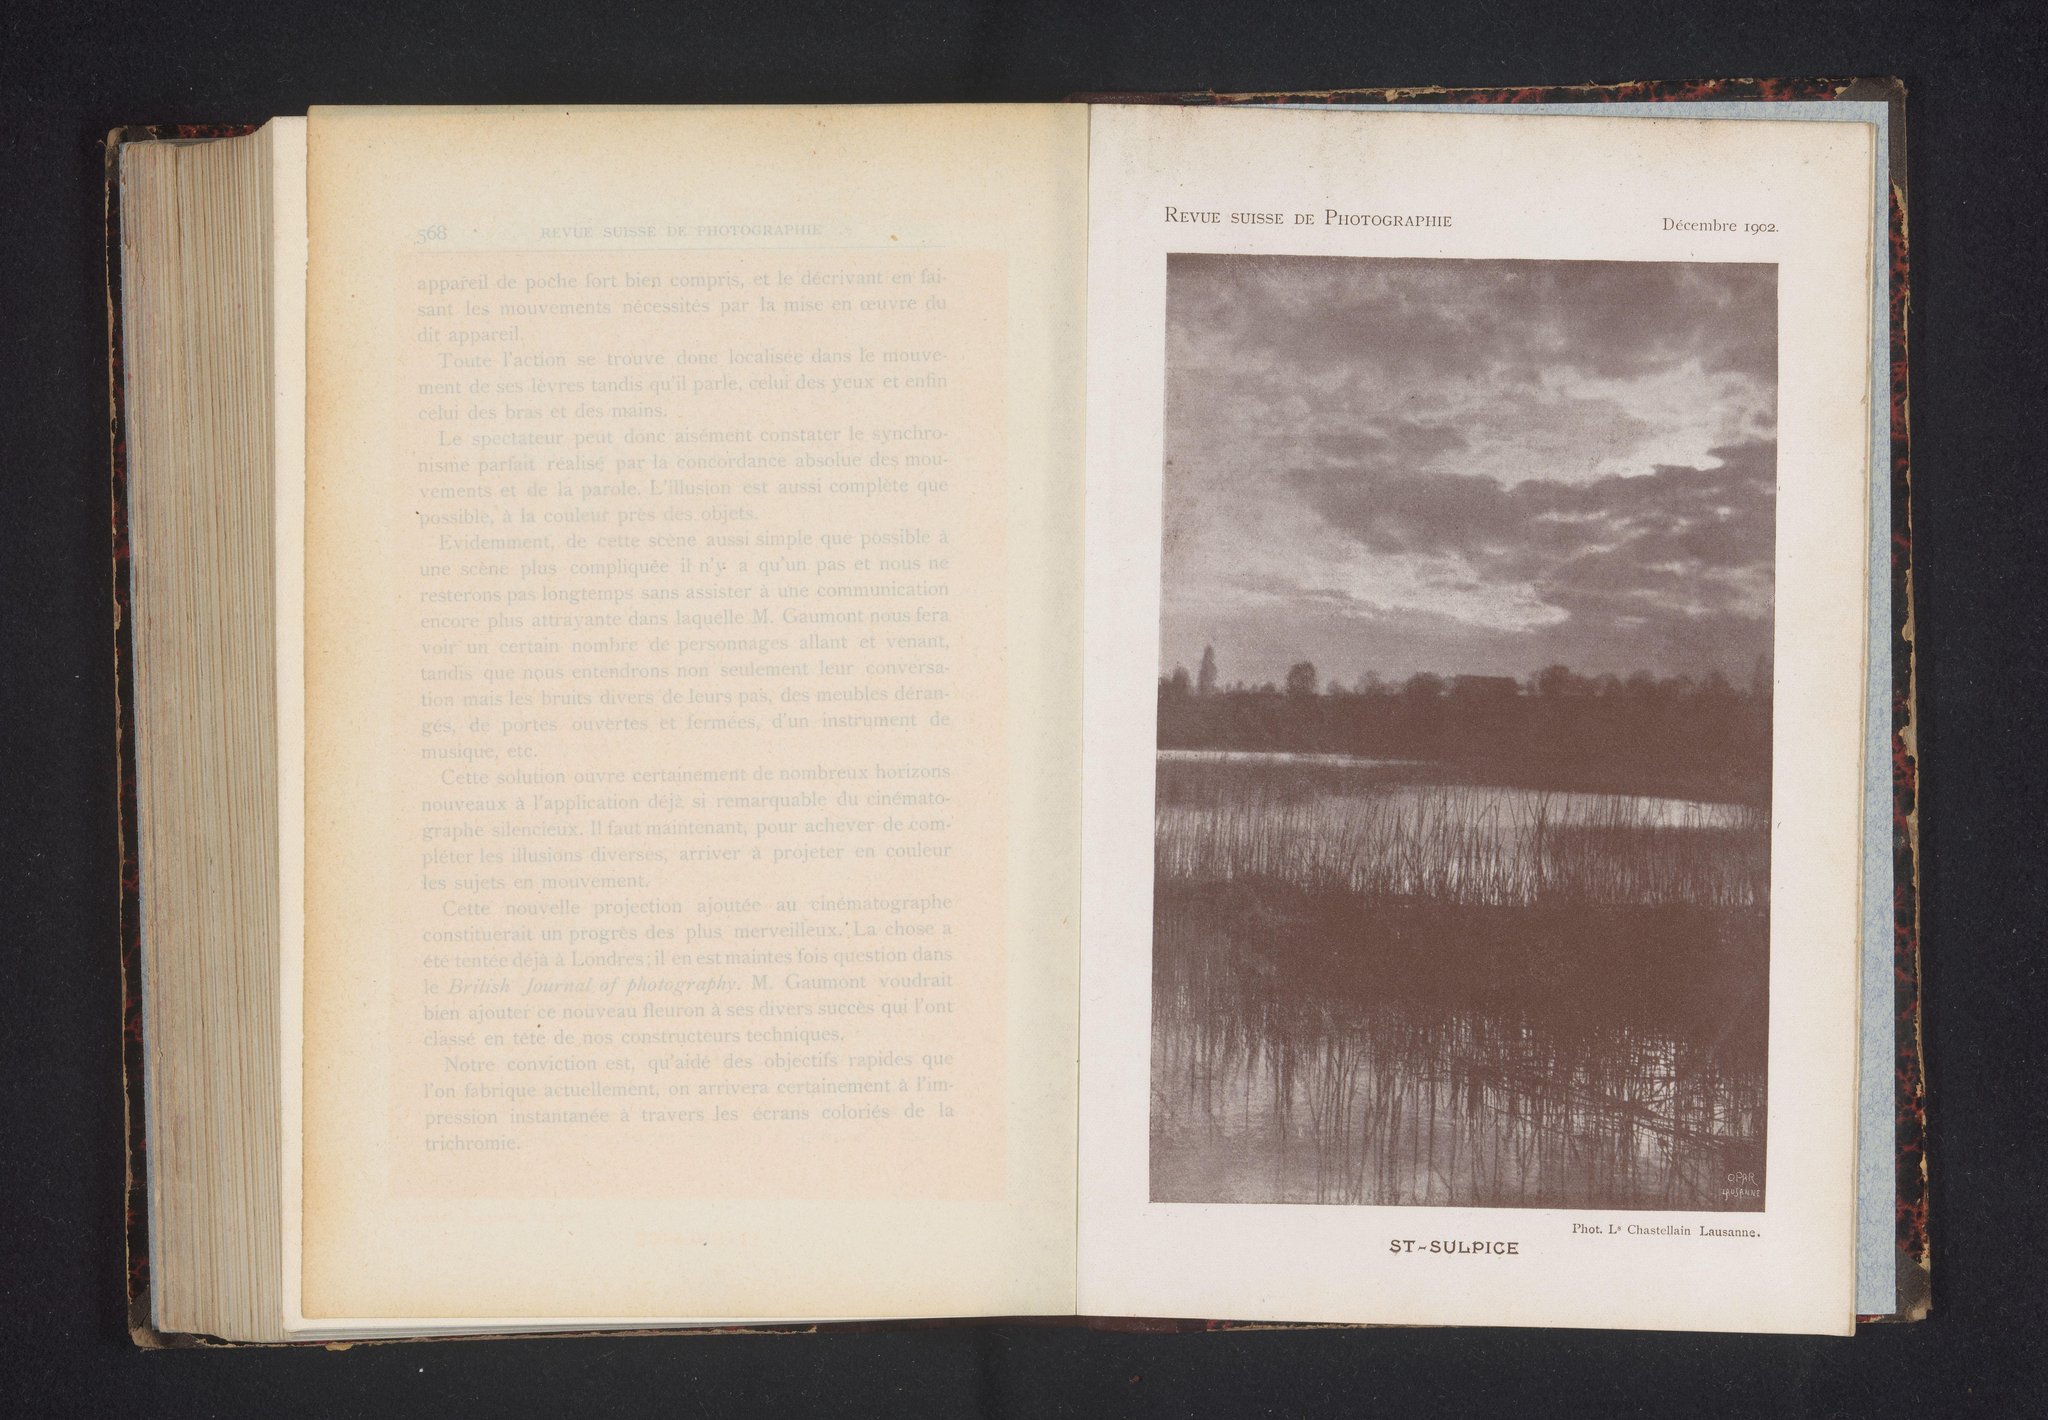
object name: photomechanical print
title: Landschap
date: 1897-1902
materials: paper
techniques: autotype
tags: landscapes with waters, waterscapes, seascapes (in the temperate zone)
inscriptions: inscription: ‘Revue suisse de Photographie’, monogram: ‘OPAR/ Lausanne’